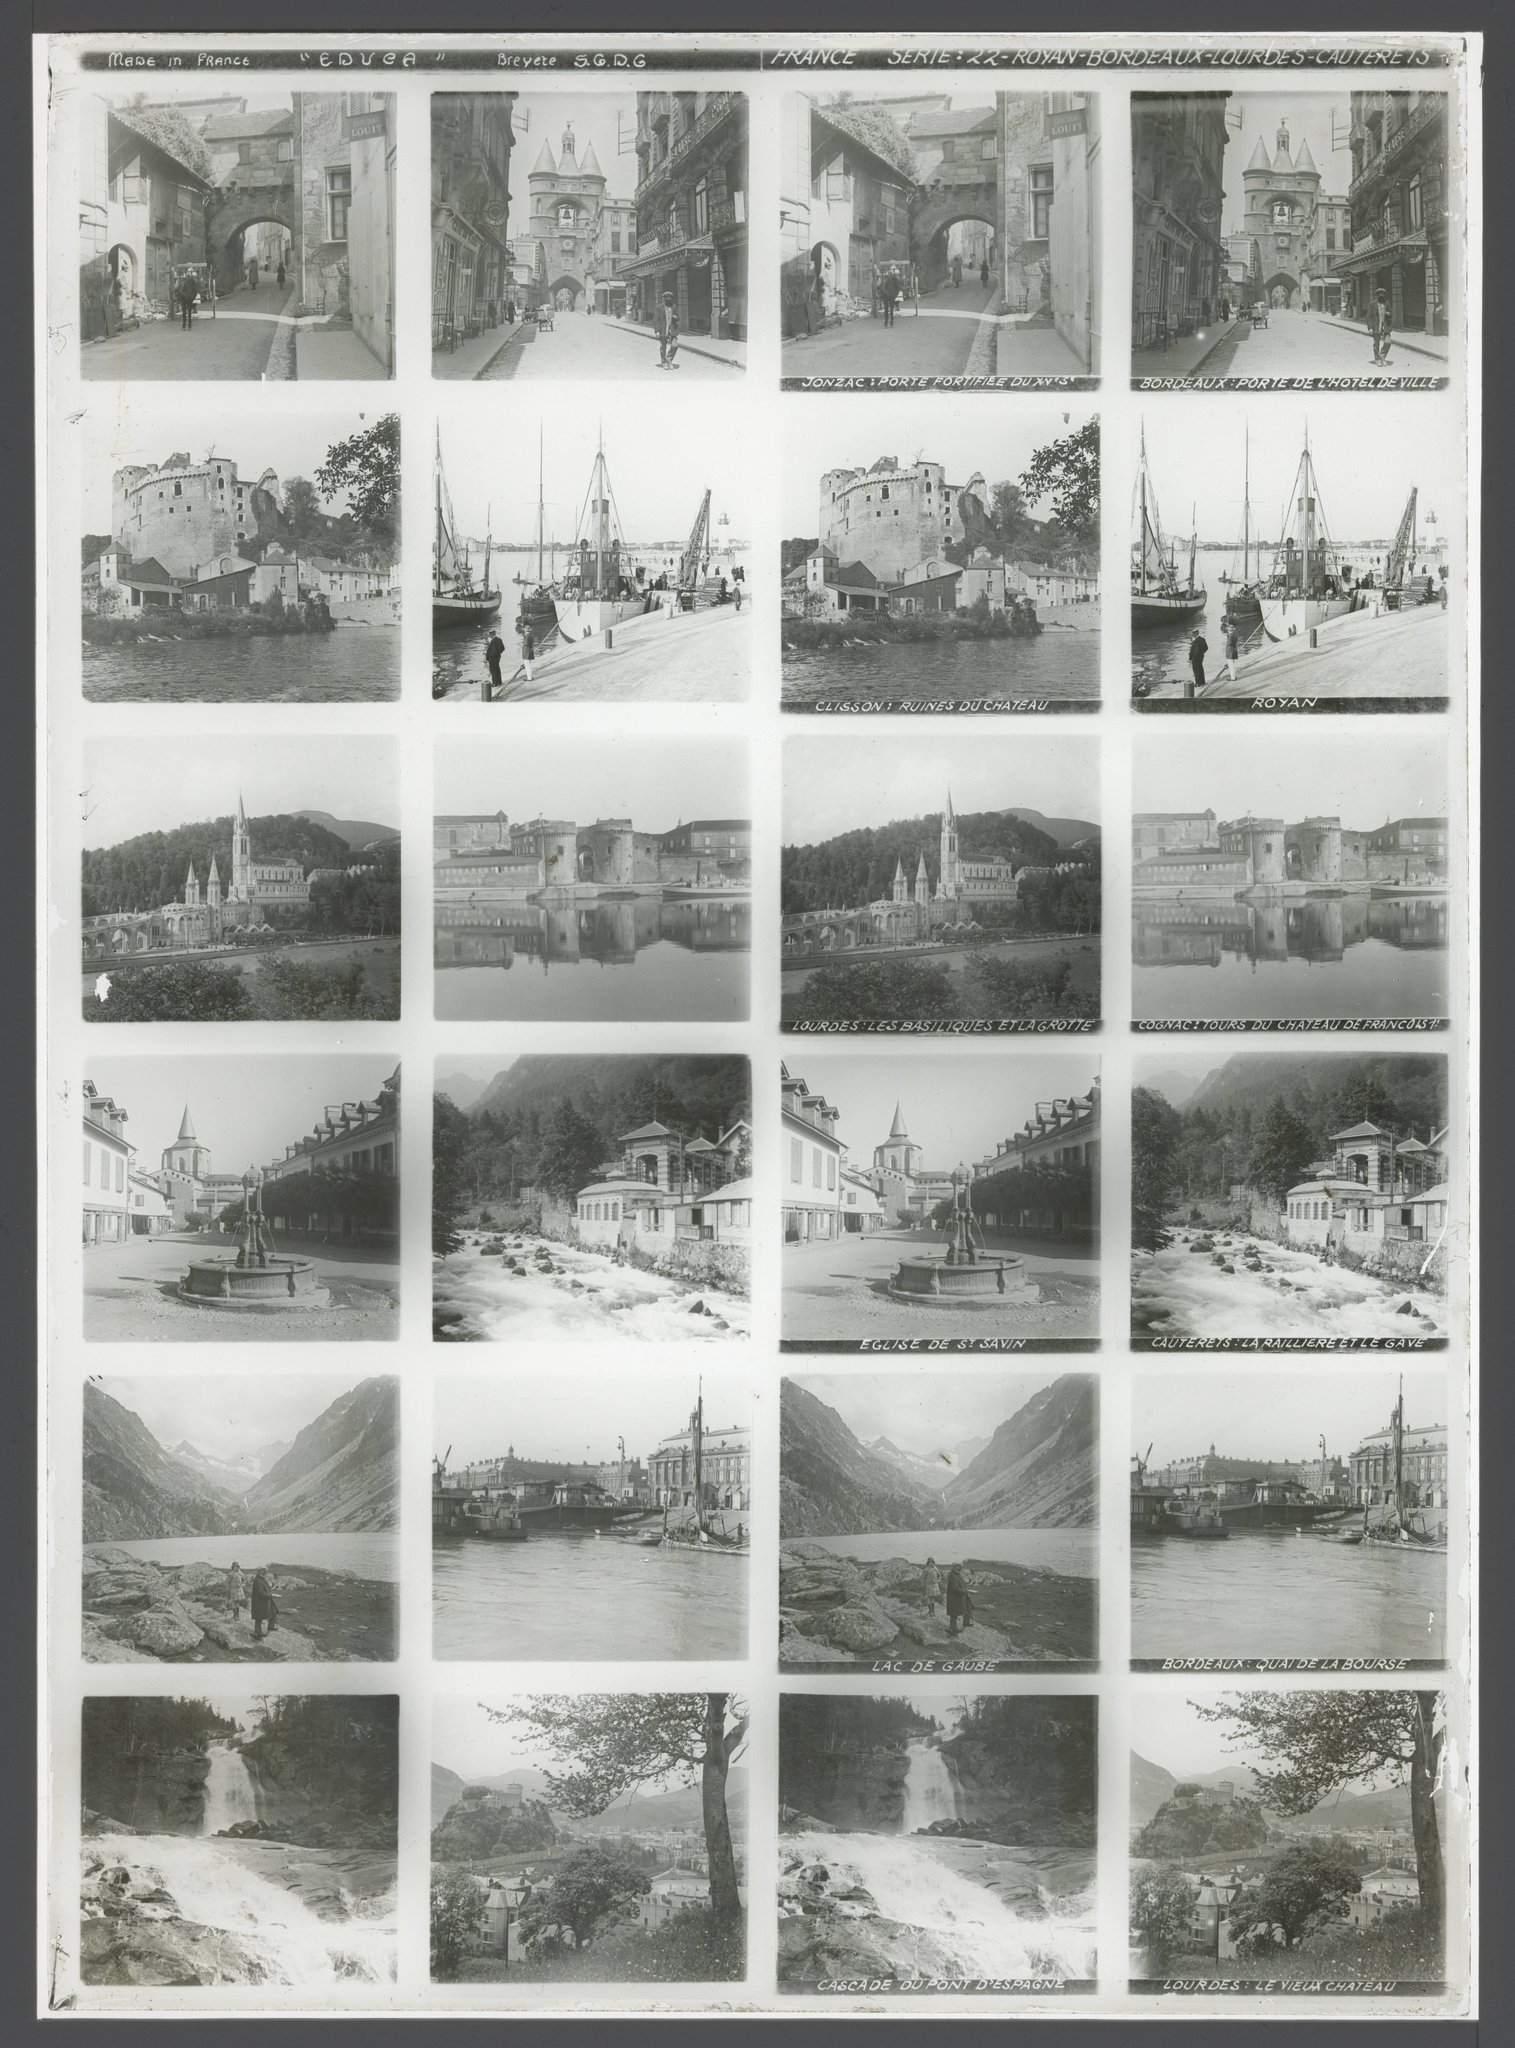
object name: stereoscopic photograph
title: Twaalf stereoscopische opnamen uit de omgeving van Bordeaux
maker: Anonymous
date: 1920-1925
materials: glass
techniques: gelatin silver transparency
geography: paris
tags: harbour, castle, lake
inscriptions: inscription: ‘Made in France (...) Brevete S.G.D.G. (...)’